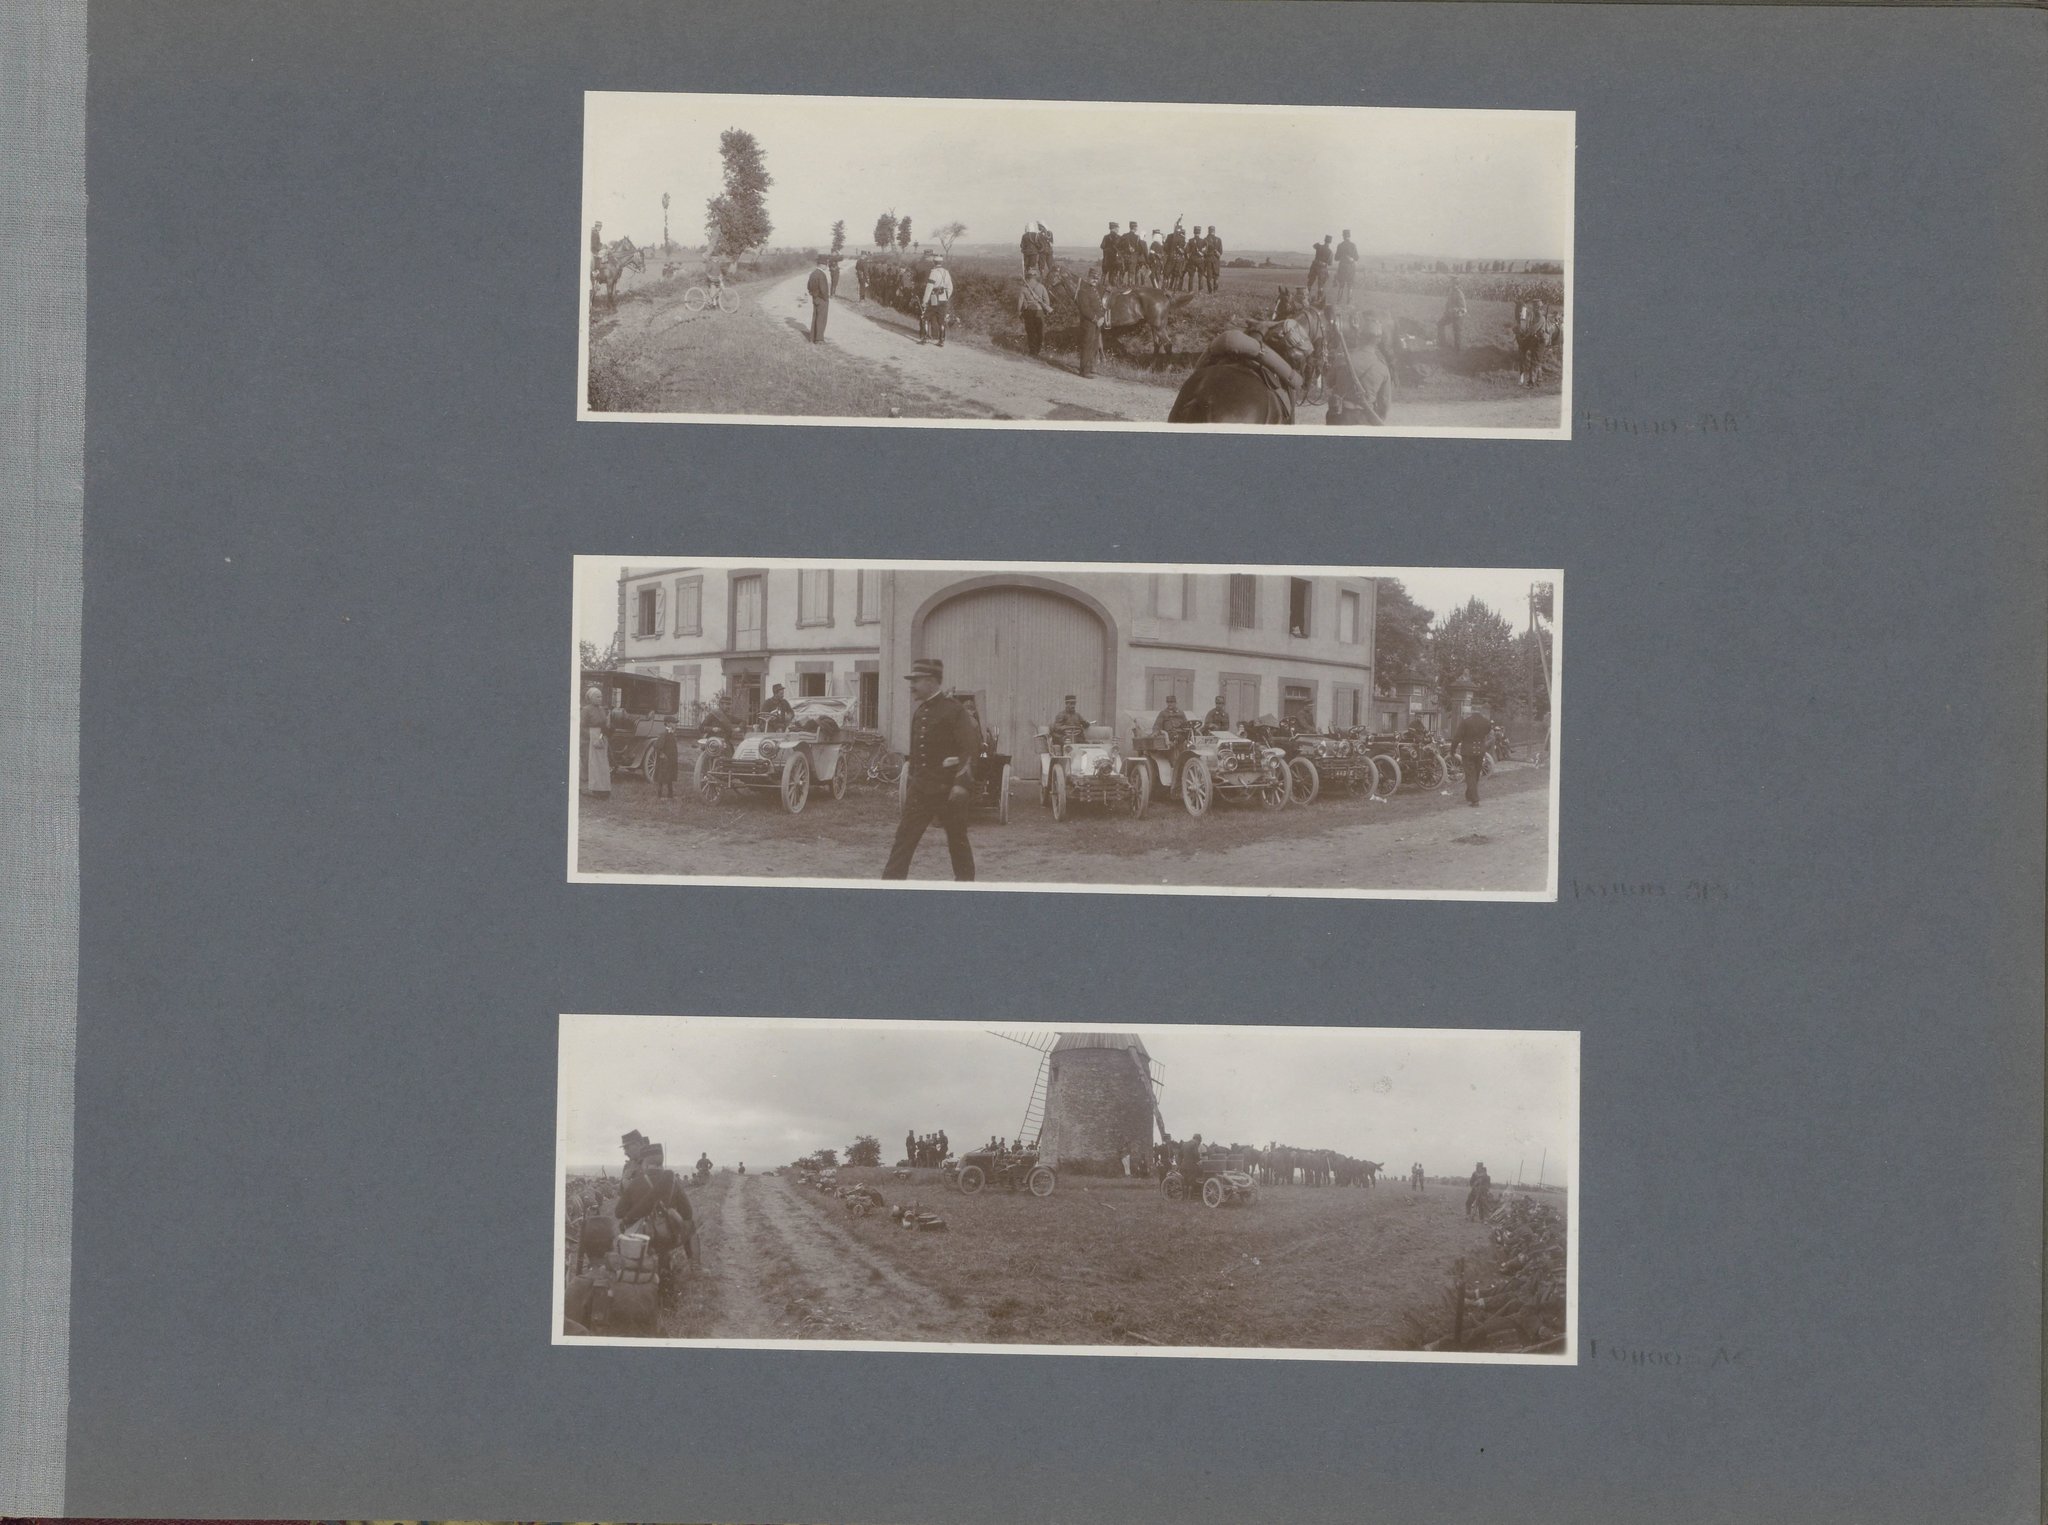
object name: album leaf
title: Militairen met auto's, paarden en ransels voor een windmolen in Frankrijk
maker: Anonymous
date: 1902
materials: paper, photographic support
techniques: daylight paper print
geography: france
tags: manoeuvre ~ military training, land forces, knapsack, rucksack, automobile, windmill, france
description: Onderdeel van Fotoalbum van een legeroefening in Zuidwest-Frankrijk in 1902.